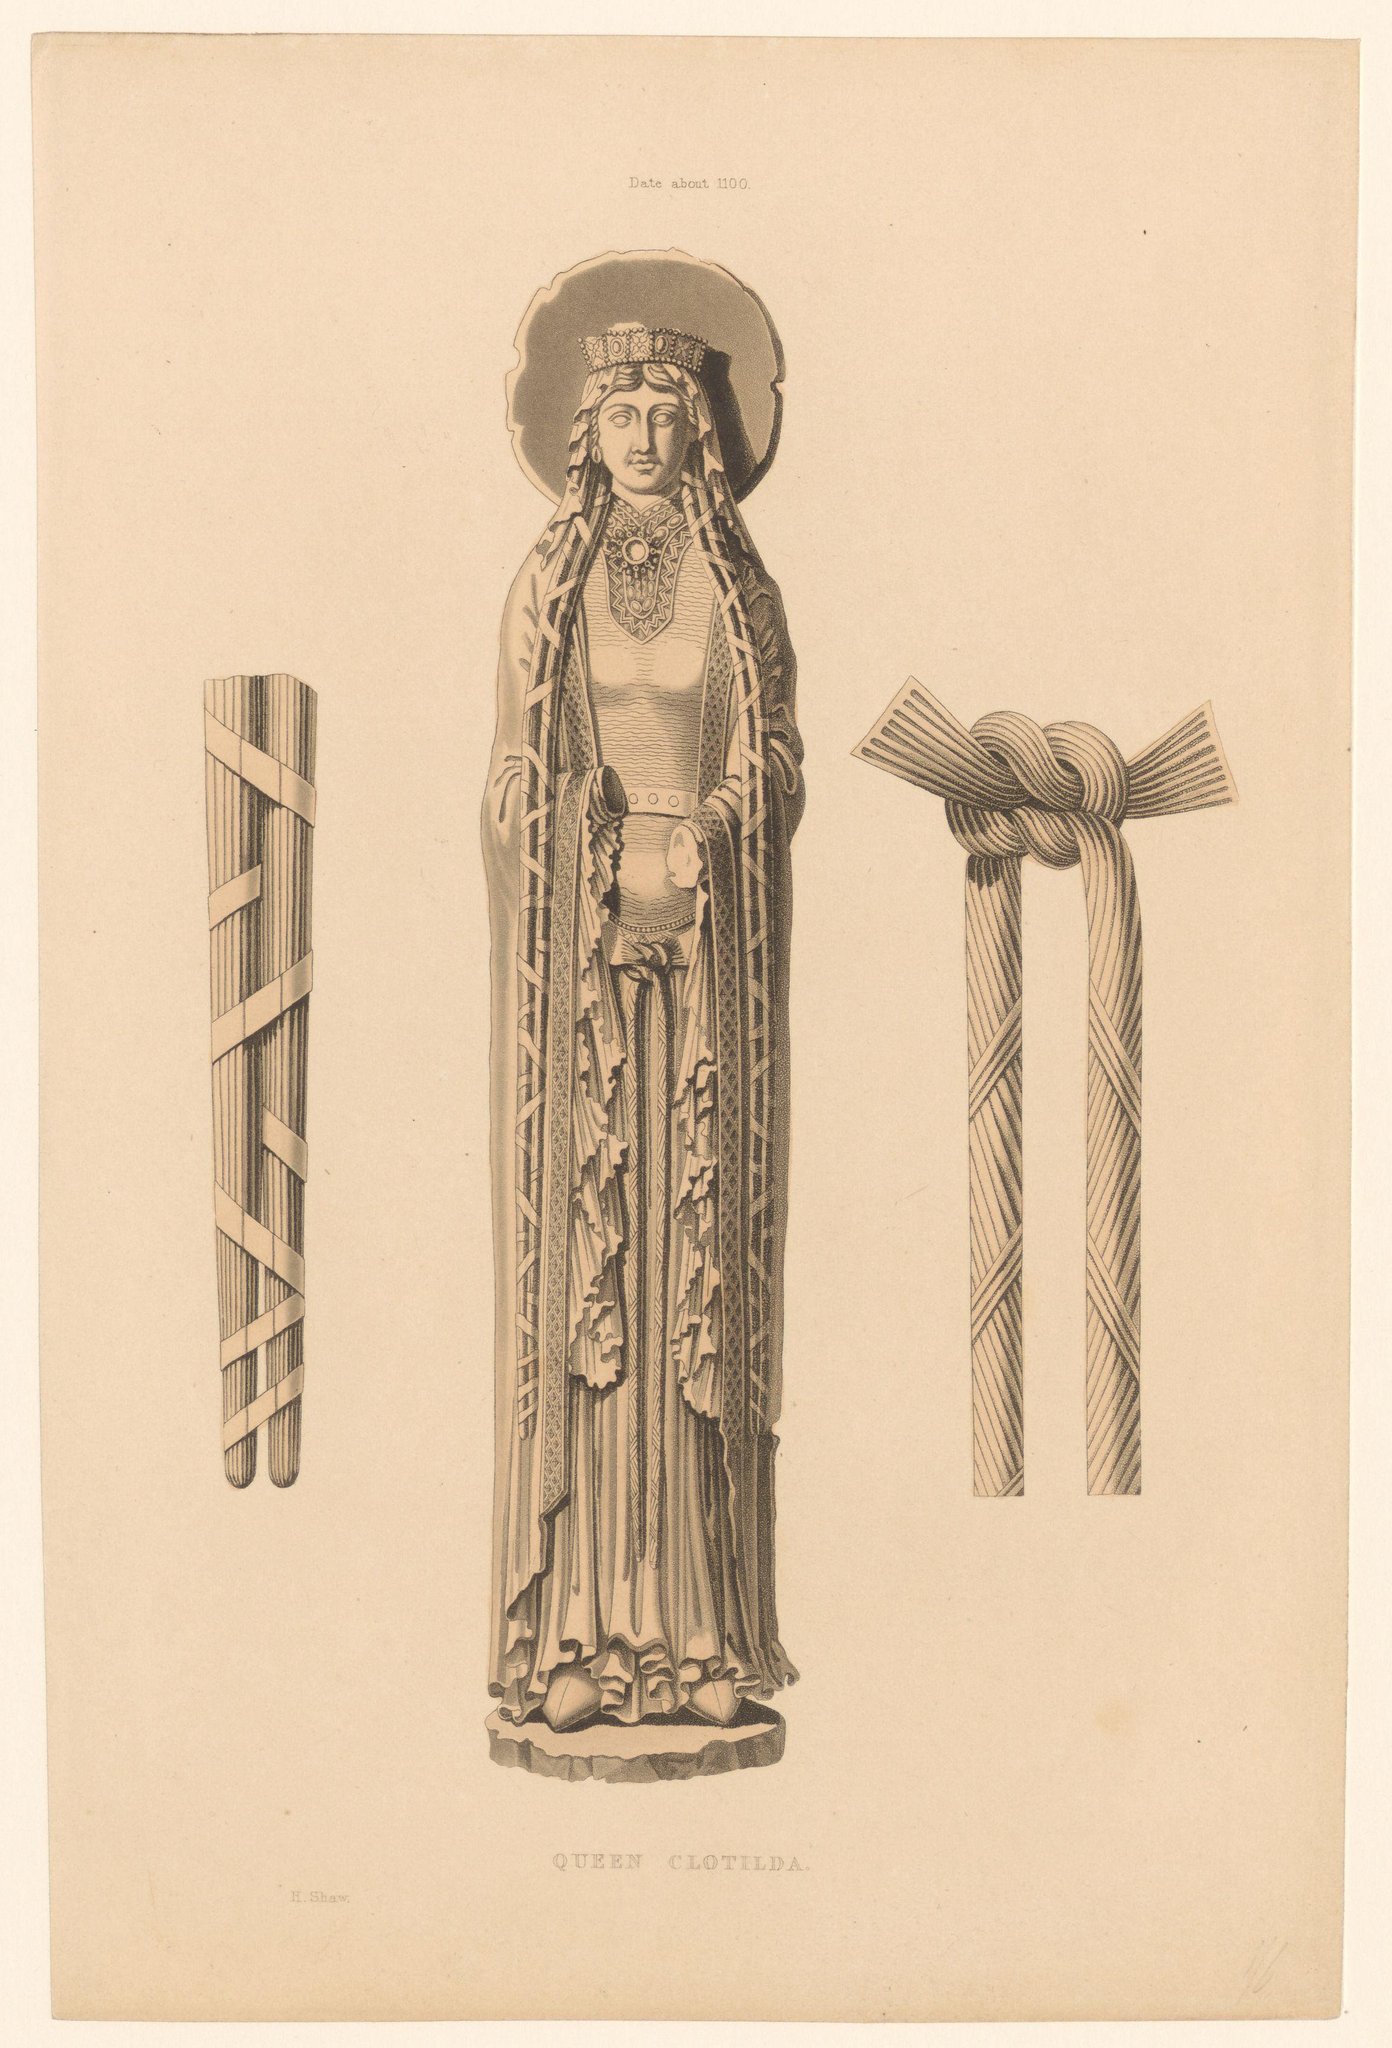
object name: print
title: Queen Clotilda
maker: henry shaw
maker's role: print maker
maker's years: 1800-1873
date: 1810-1873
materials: paper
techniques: aquatint, etching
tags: paris, queen, sculpture, ornament derived from architectural details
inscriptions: collector's mark: Lugt 2228